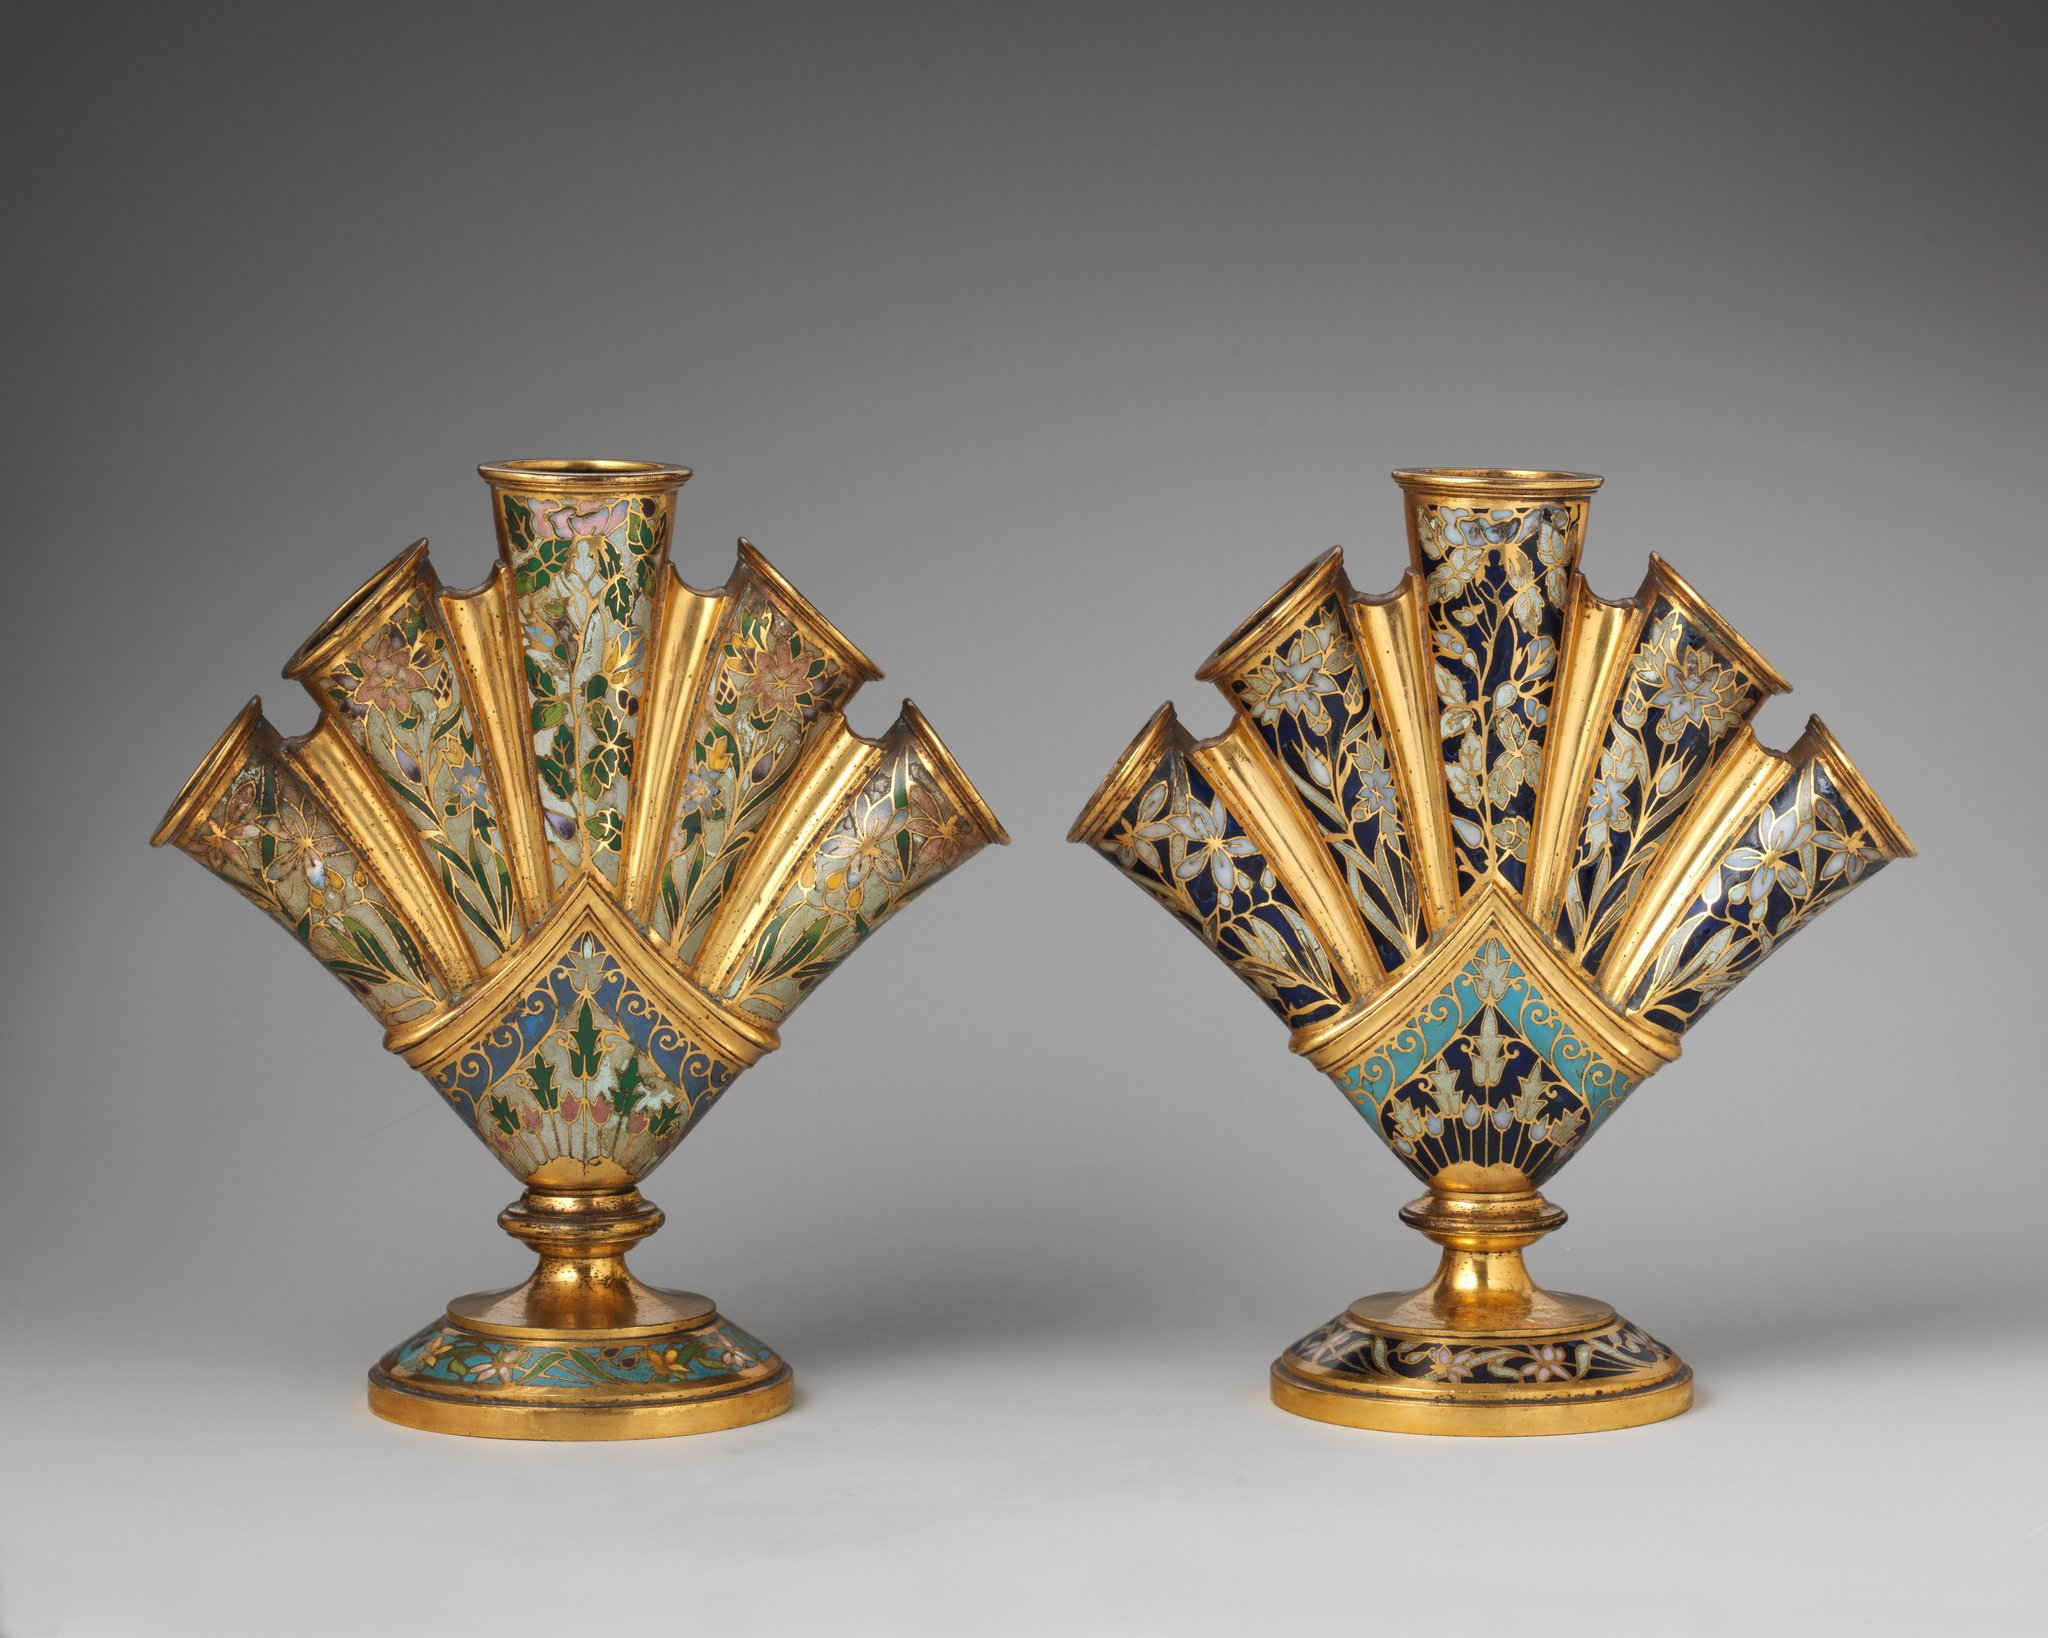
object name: tulip vase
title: Tulip vases (2)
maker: elkington & co.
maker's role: factory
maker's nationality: british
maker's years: 1829-1963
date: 1885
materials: enamel, gilt bronze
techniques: enamel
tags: tulips